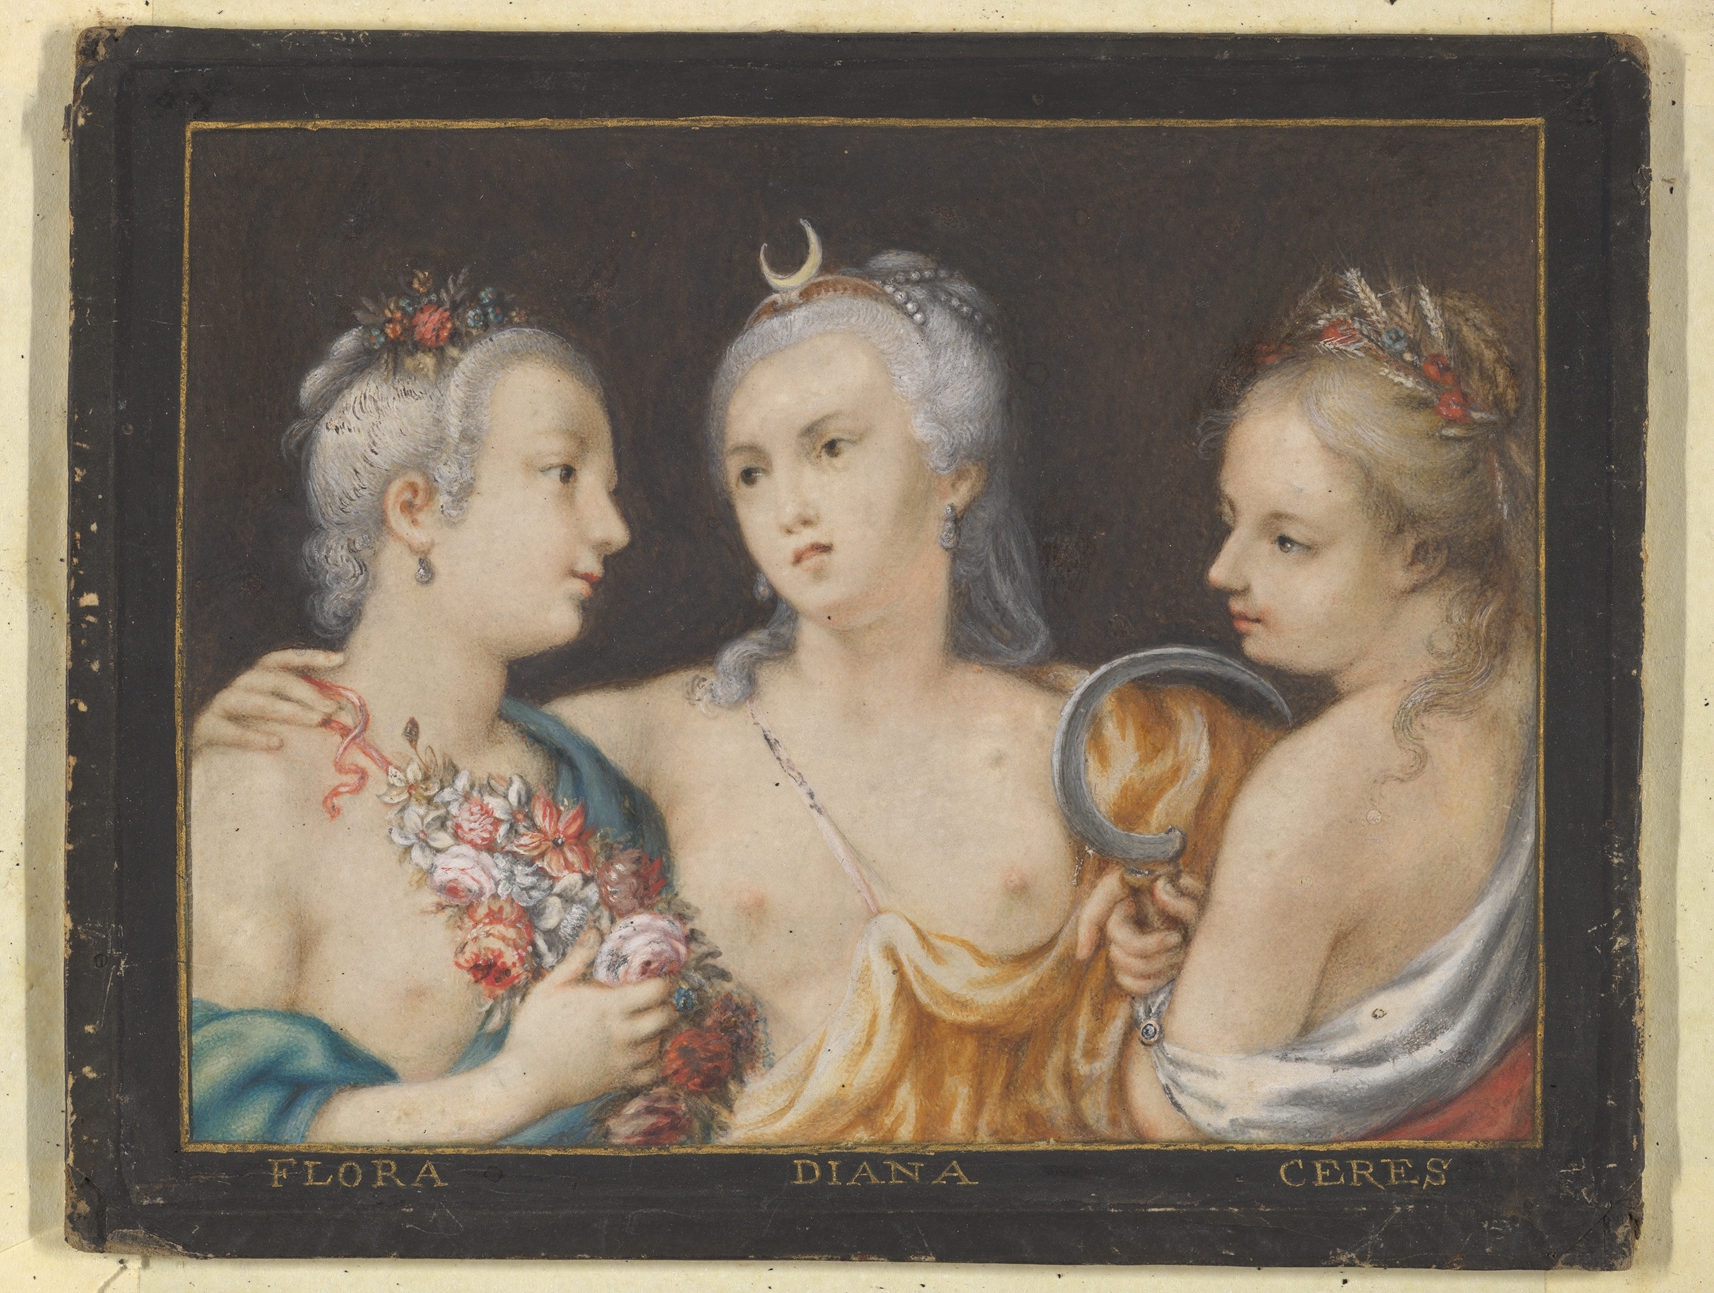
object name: drawing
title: Heads of Goddesses (Flora, Diana, Ceres)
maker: anonymous, french, 17th century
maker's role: artist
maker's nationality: french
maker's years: 1600-1700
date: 1600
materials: gold, gouache, ink, watercolor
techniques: pen, wash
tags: ceres,diana,goddess